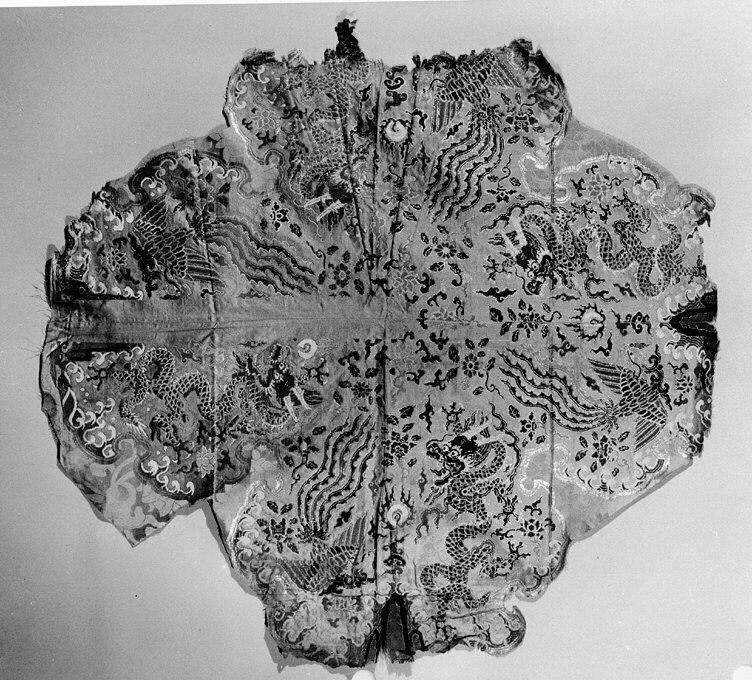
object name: woman's wedding collar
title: Woman's Wedding Collar (?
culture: chinese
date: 1767-1833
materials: silk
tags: dragons,flowers